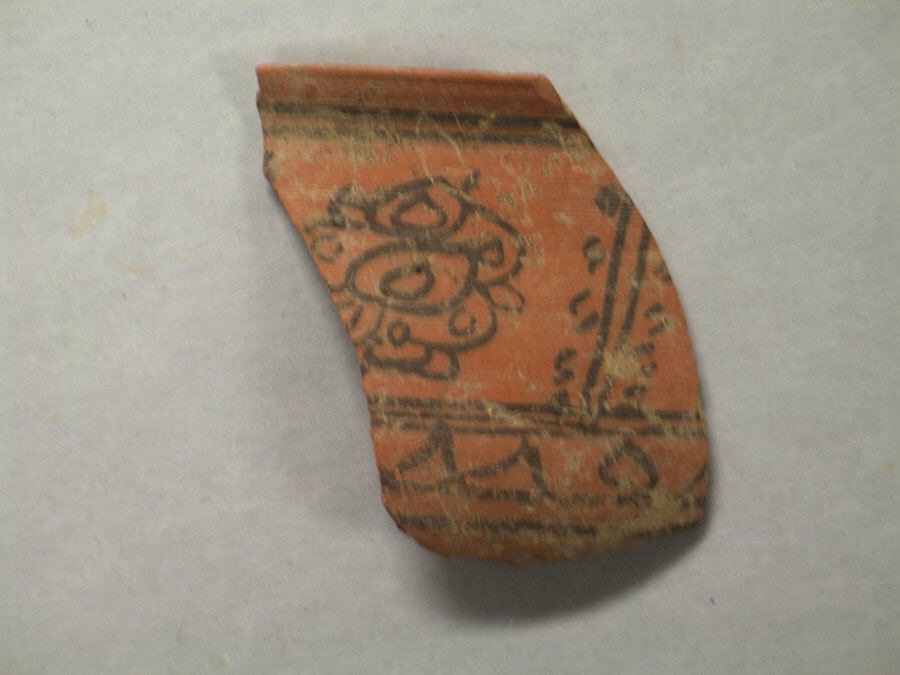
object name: shard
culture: pakistani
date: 301-500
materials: terracotta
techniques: painting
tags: gandhara